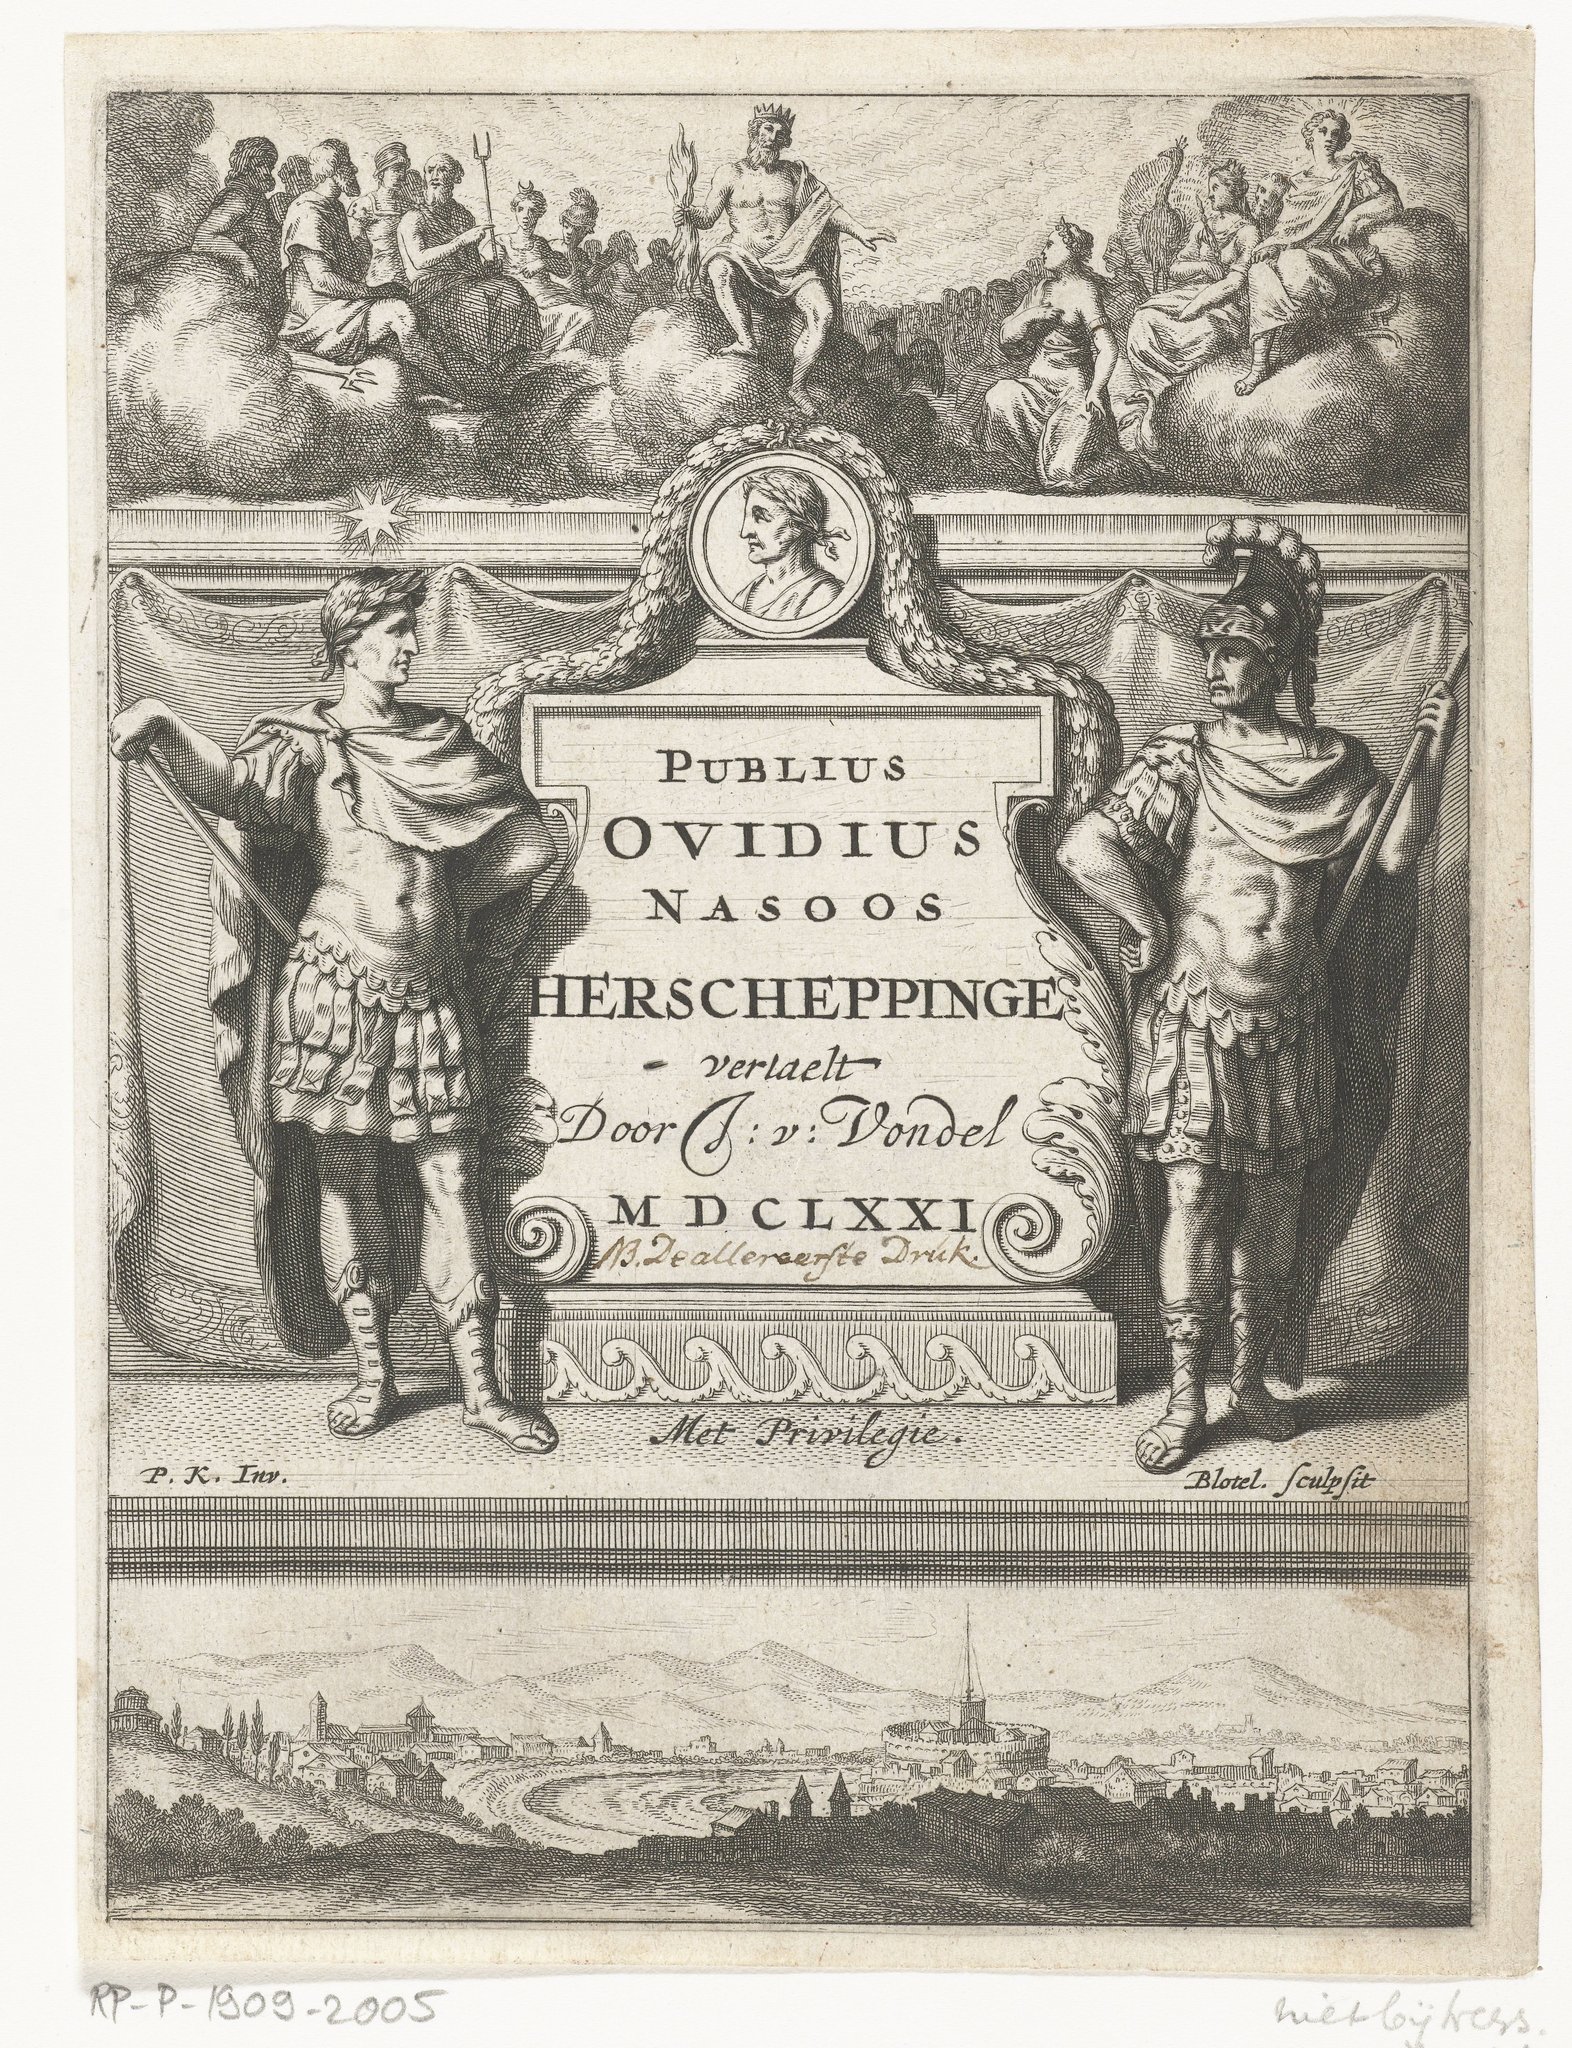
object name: titelblad, titelpagina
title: Titelpagina voor J. van Vondels vertaling van P.O. Naso, Herscheppinge, Amsterdam 1671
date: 1671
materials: paper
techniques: engraving, etching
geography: amsterdam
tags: city-view in general; 'veduta', olympus, rome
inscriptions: collector's mark: Lugt 2228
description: Twee Romeinse veldheren staan naast een tafel met de titel van het boek. Boven de tafel een afbeelding van het Olymp met een verzameling van de goden. Onder de tafel een gezicht op een stad, waarschijnlijk Rome.